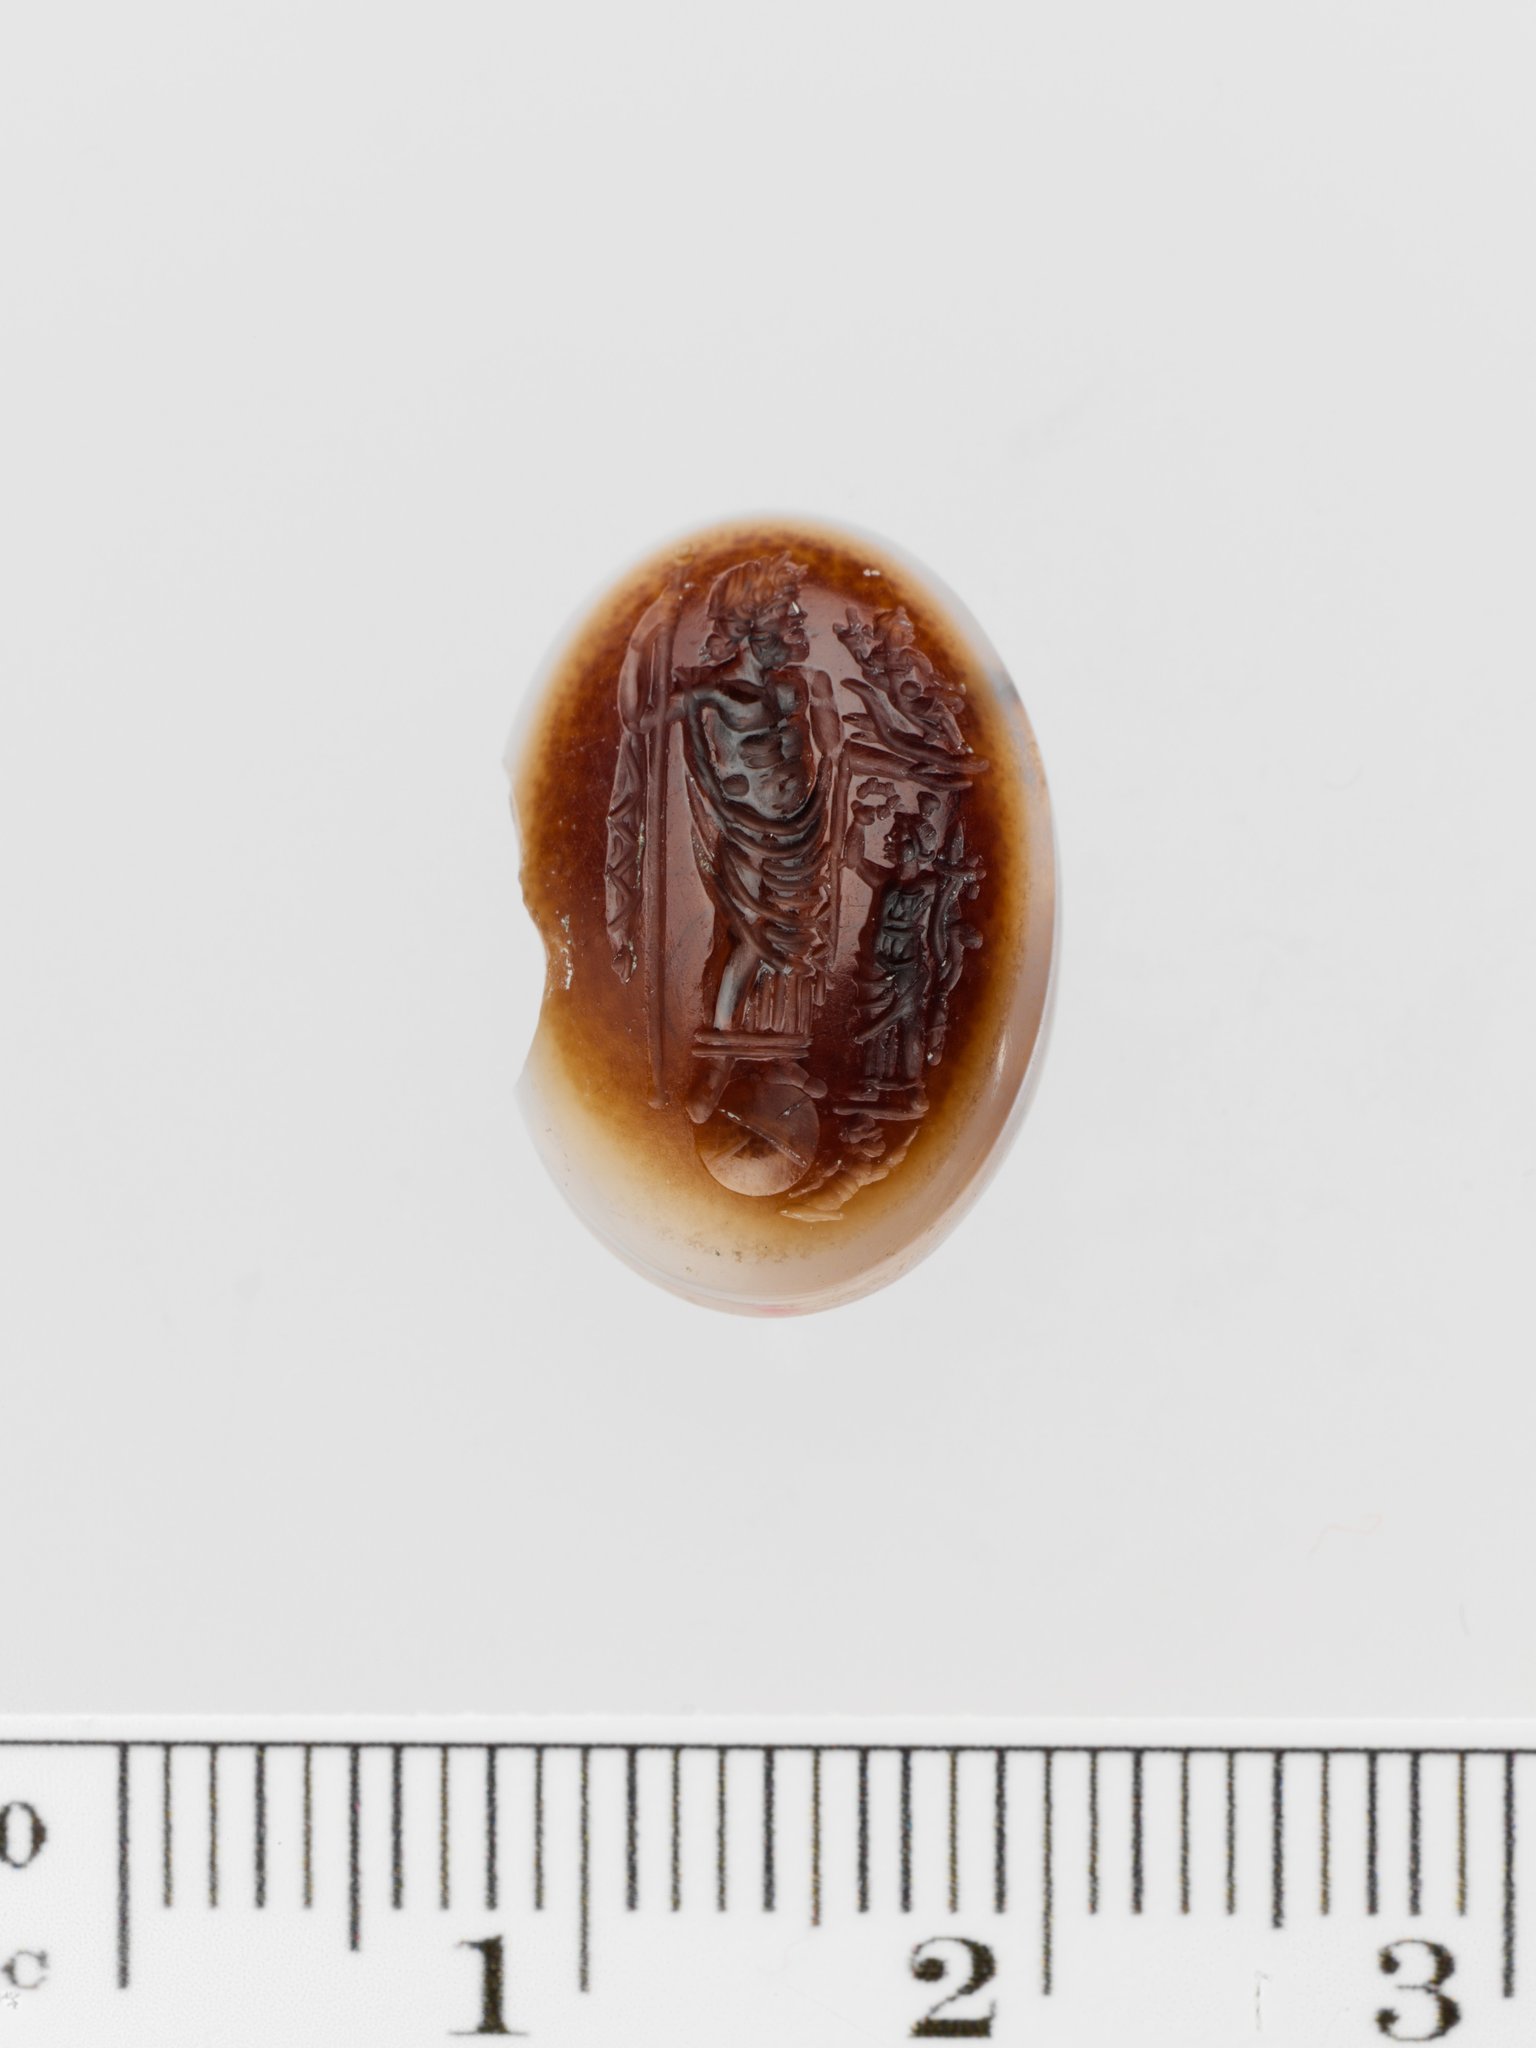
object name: intaglio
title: Sardonyx ring stone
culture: roman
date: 100 BCE-300 CE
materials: gemstone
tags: zeus